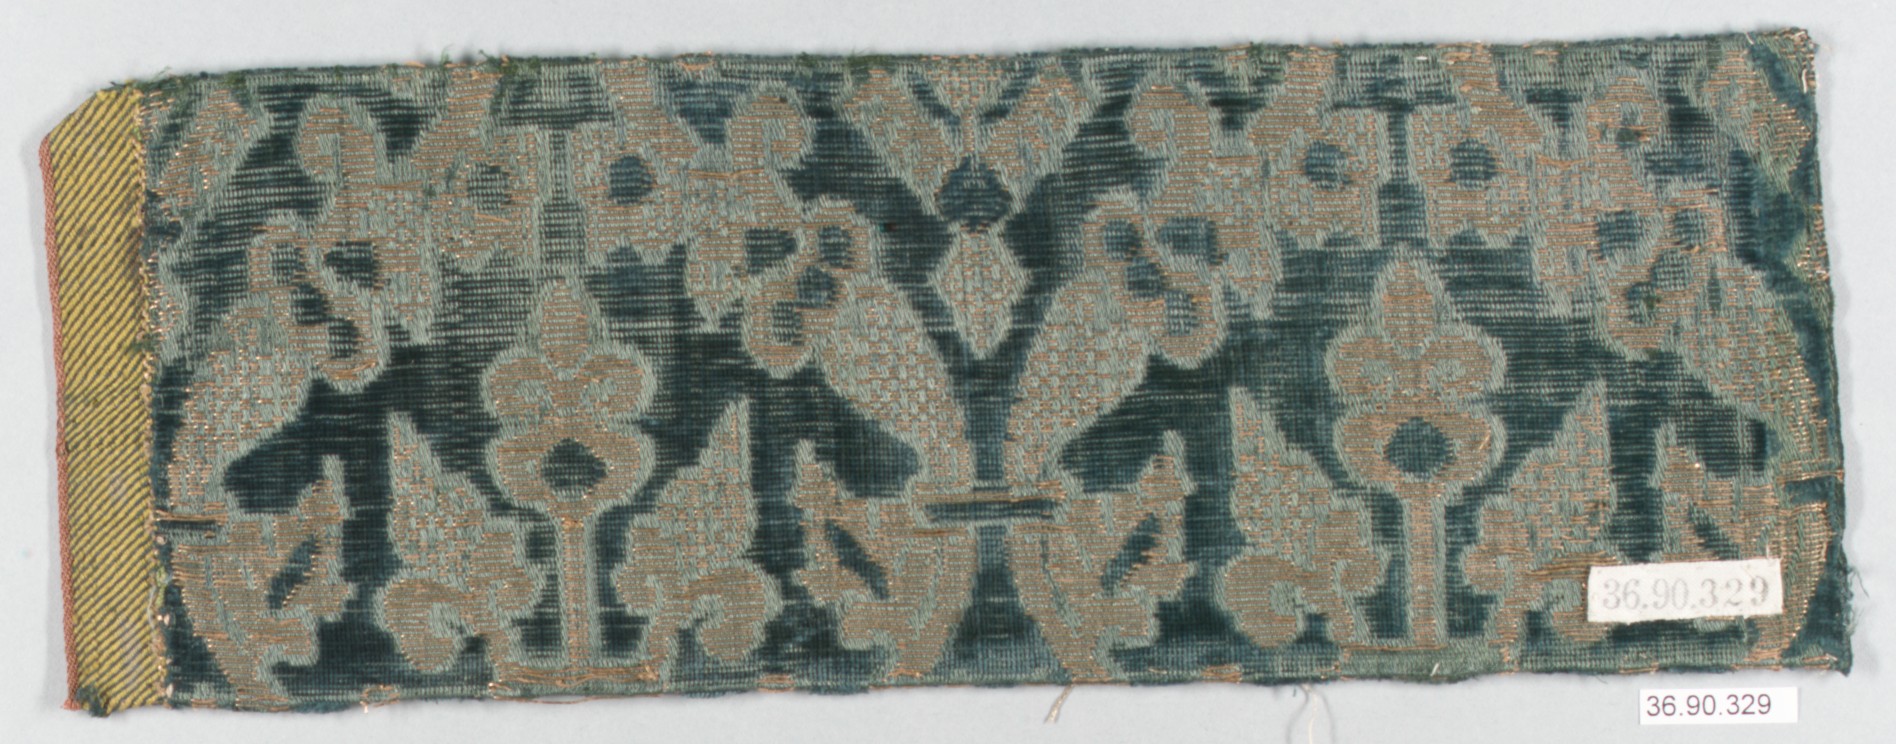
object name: piece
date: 1501-1700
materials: metal thread, silk